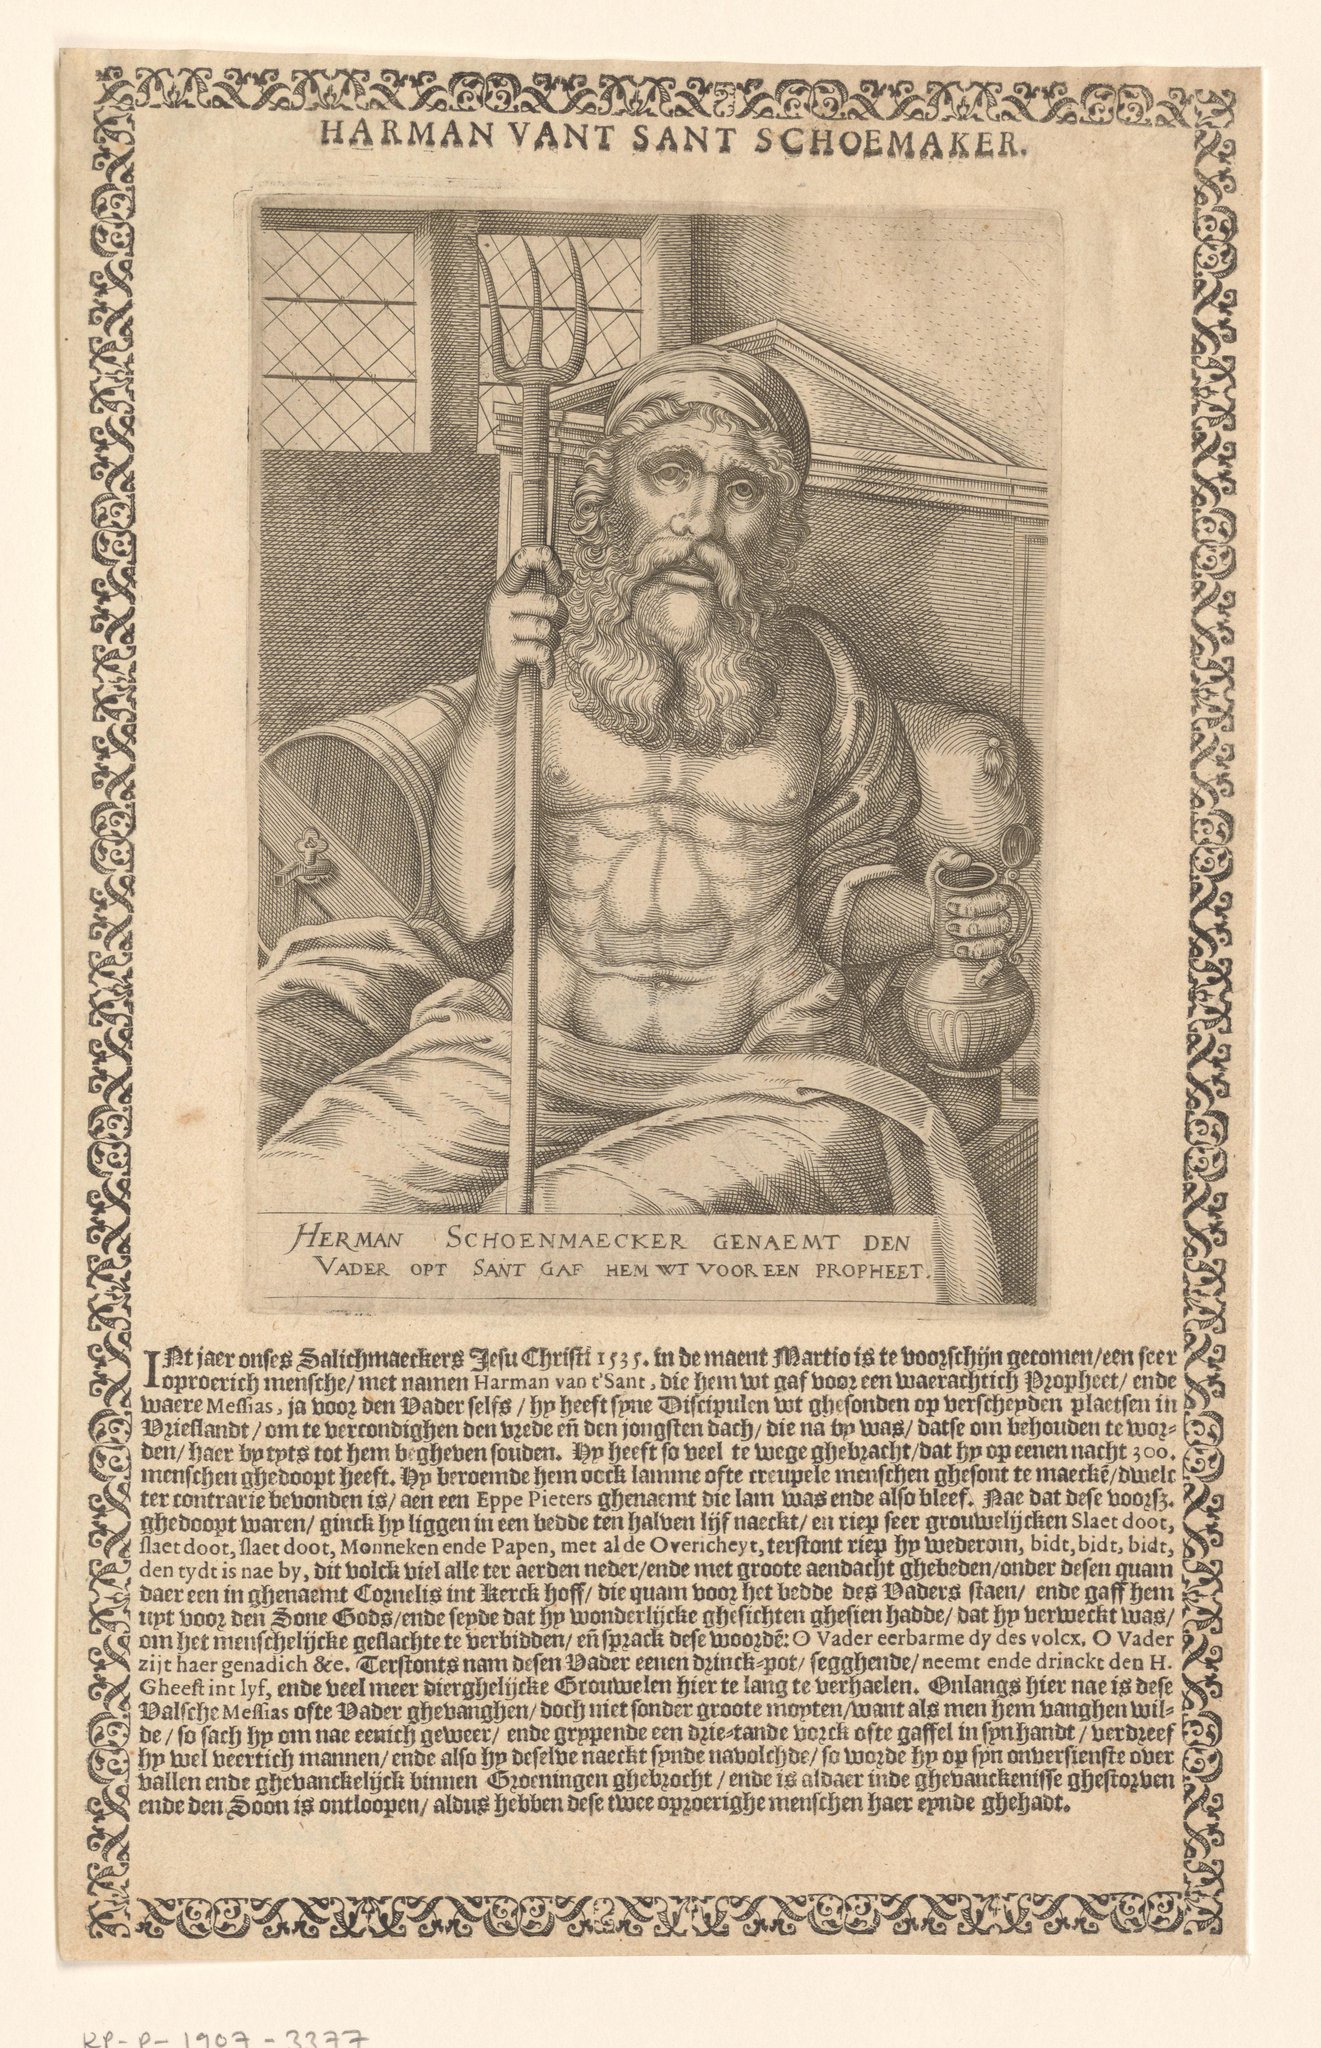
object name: print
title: Portret van Hermannus de Schoenmaker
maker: christoffel van sichem (i)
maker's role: print maker, publisher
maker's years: 1546-1624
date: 1608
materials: paper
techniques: engraving, letterpress printing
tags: agricultural implements: pitchfork, historical persons, (single) prophet, unspecified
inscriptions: collector's mark: Lugt 2228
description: Prent met andere tekst op recto gebruikt in: Sichem, Christoffel van (I). Historische beschrĳvinge ende affbeeldinge der voorneemste hooft ketteren. Amsterdam: Christoffel van Sichem I, 1608. En in: Sichem, Christoffel van (I). Historische Beschreibüng unnd abbildünge der fürnembste Haubt-Ketzer. Amsterdam: Cornelis Claesz, 1608.